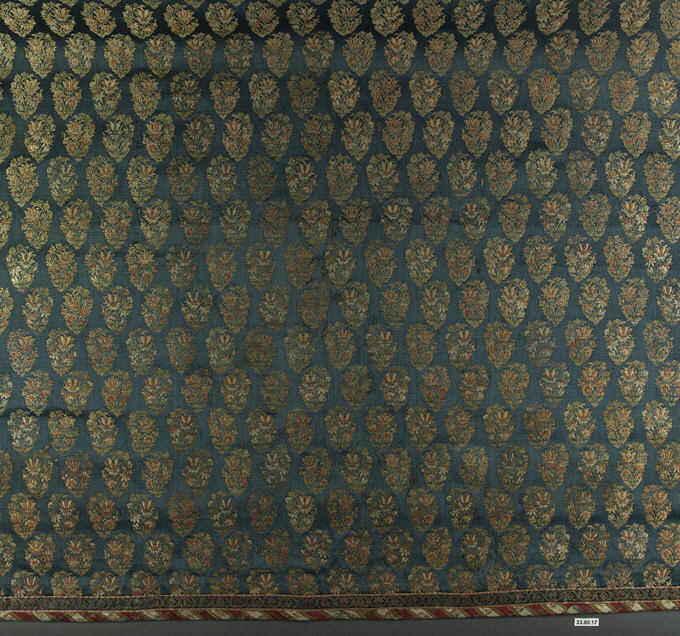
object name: cover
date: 1701-1800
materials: metal thread, silk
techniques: weave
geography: iran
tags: flowers